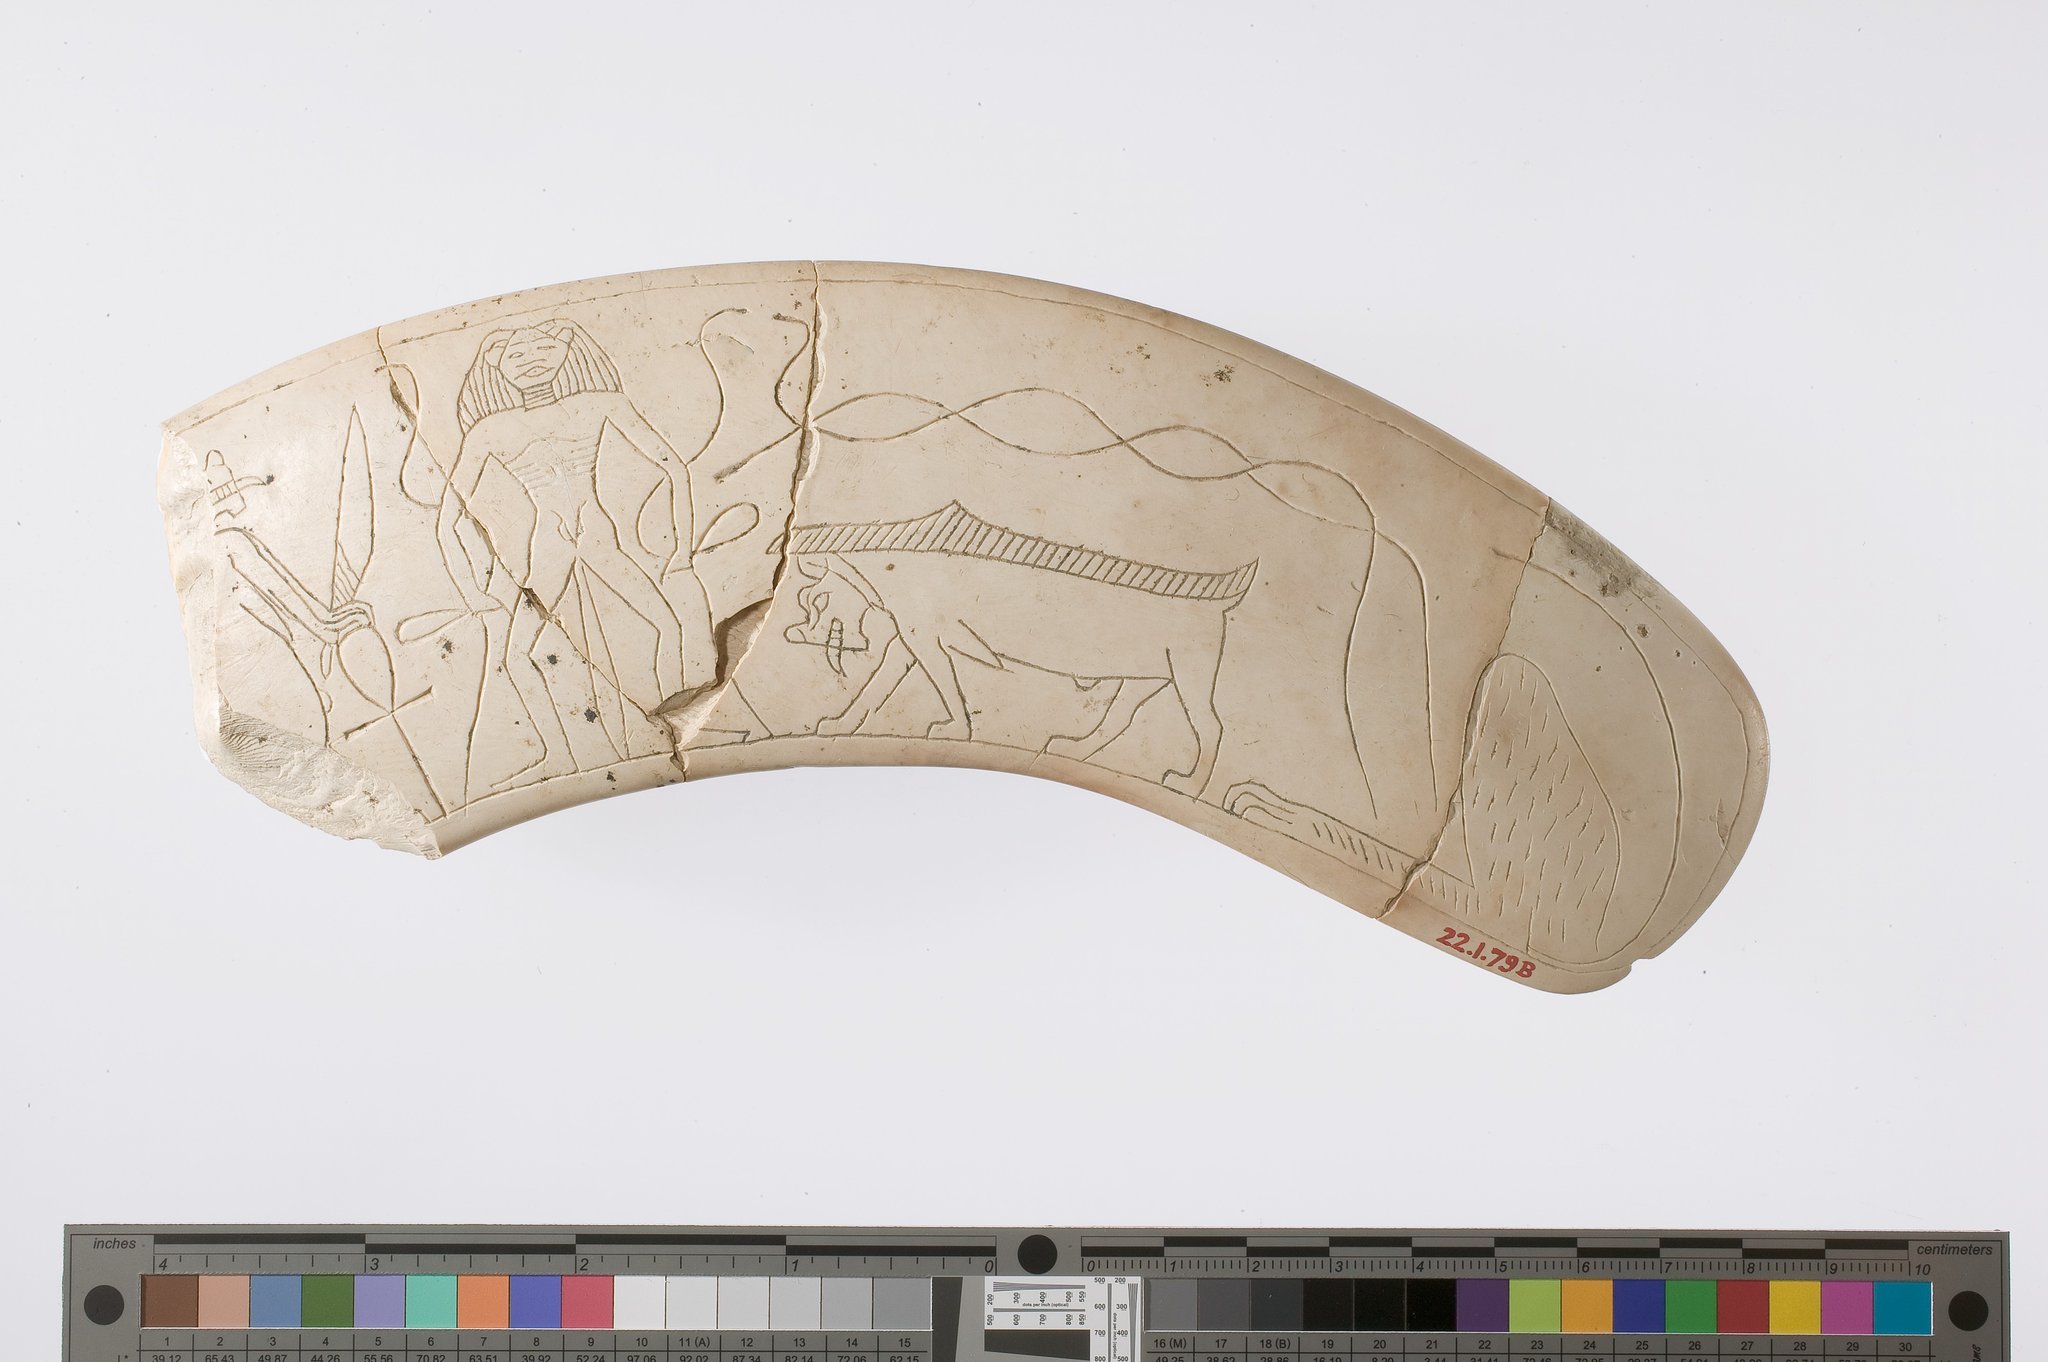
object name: magic wand fragment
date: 1850-1775 BCE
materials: ivory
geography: egypt